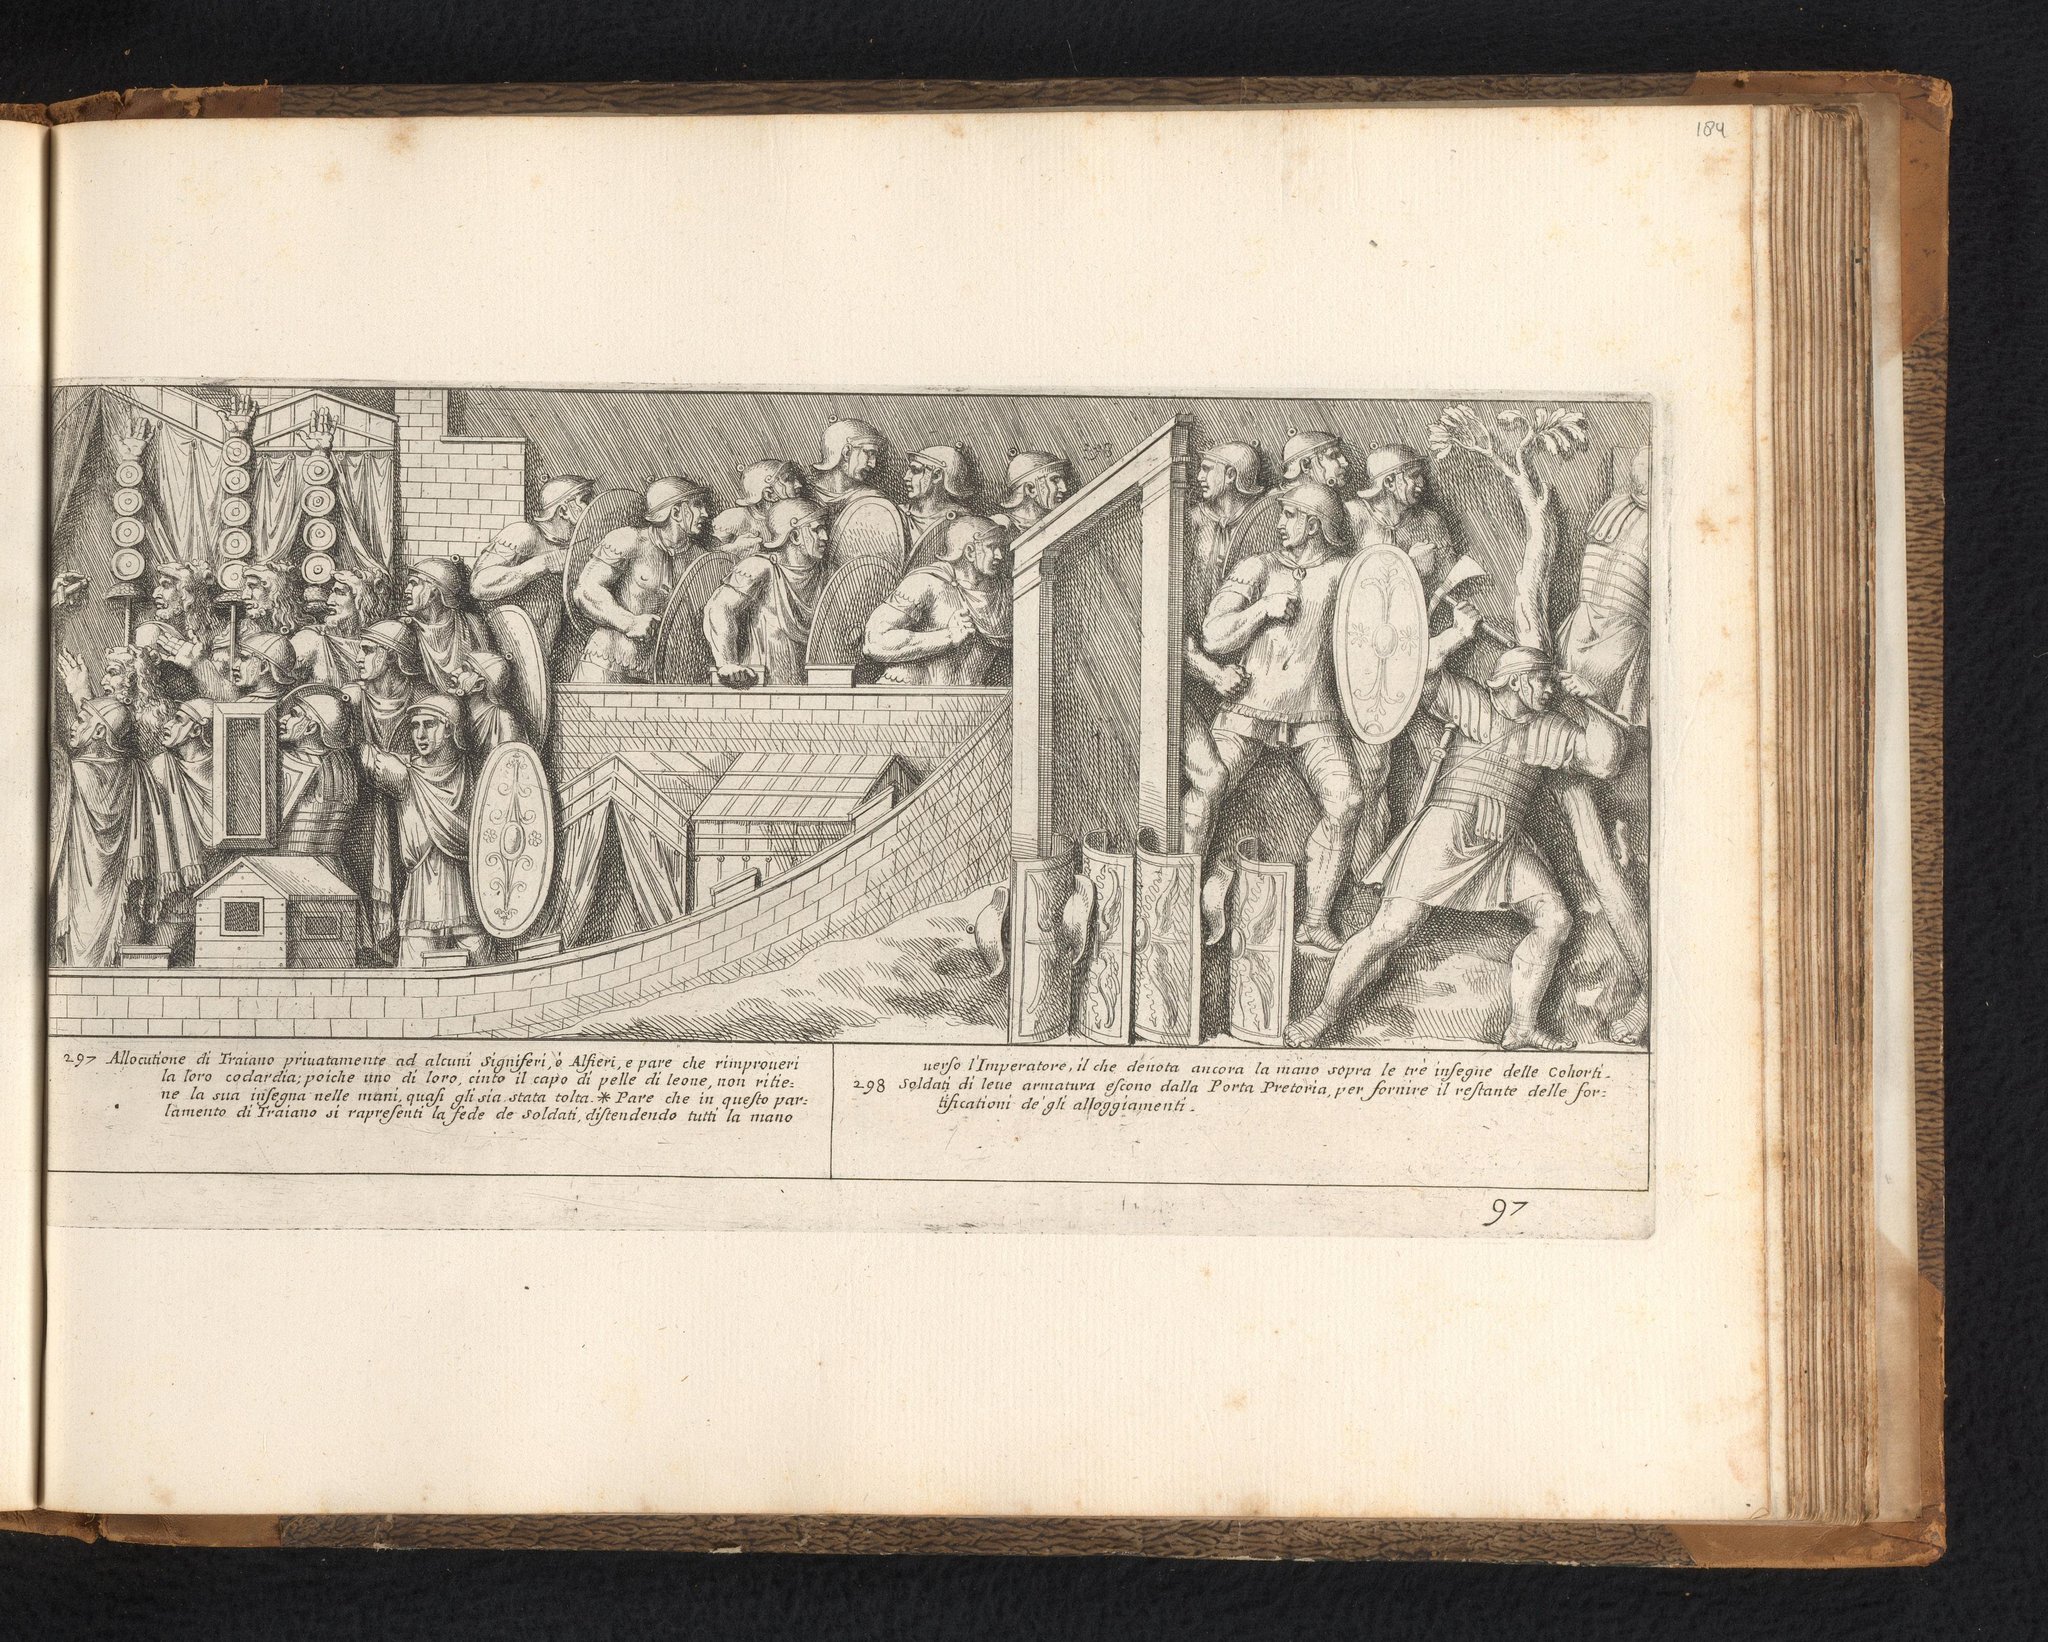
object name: album leaf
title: Colonna Traiana eretta dal senato, e popolo Romano all' imperatore Traiano Augusto nel suo foro in Rom (...)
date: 1637-1691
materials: paper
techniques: etching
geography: rome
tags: triumphal column with helical friezes, piece of sculpture, reproduction of a piece of sculpture, the soldier; the soldier's life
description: Detail van het spiraalvormige gebeeldhouwde fries op de Zuil van Trajanus. Het fries toont de oorlogen tussen de Romeinen en de Daciërs. Verklarende nummers in de ondermarge. Prent maakt deel uit van een album.